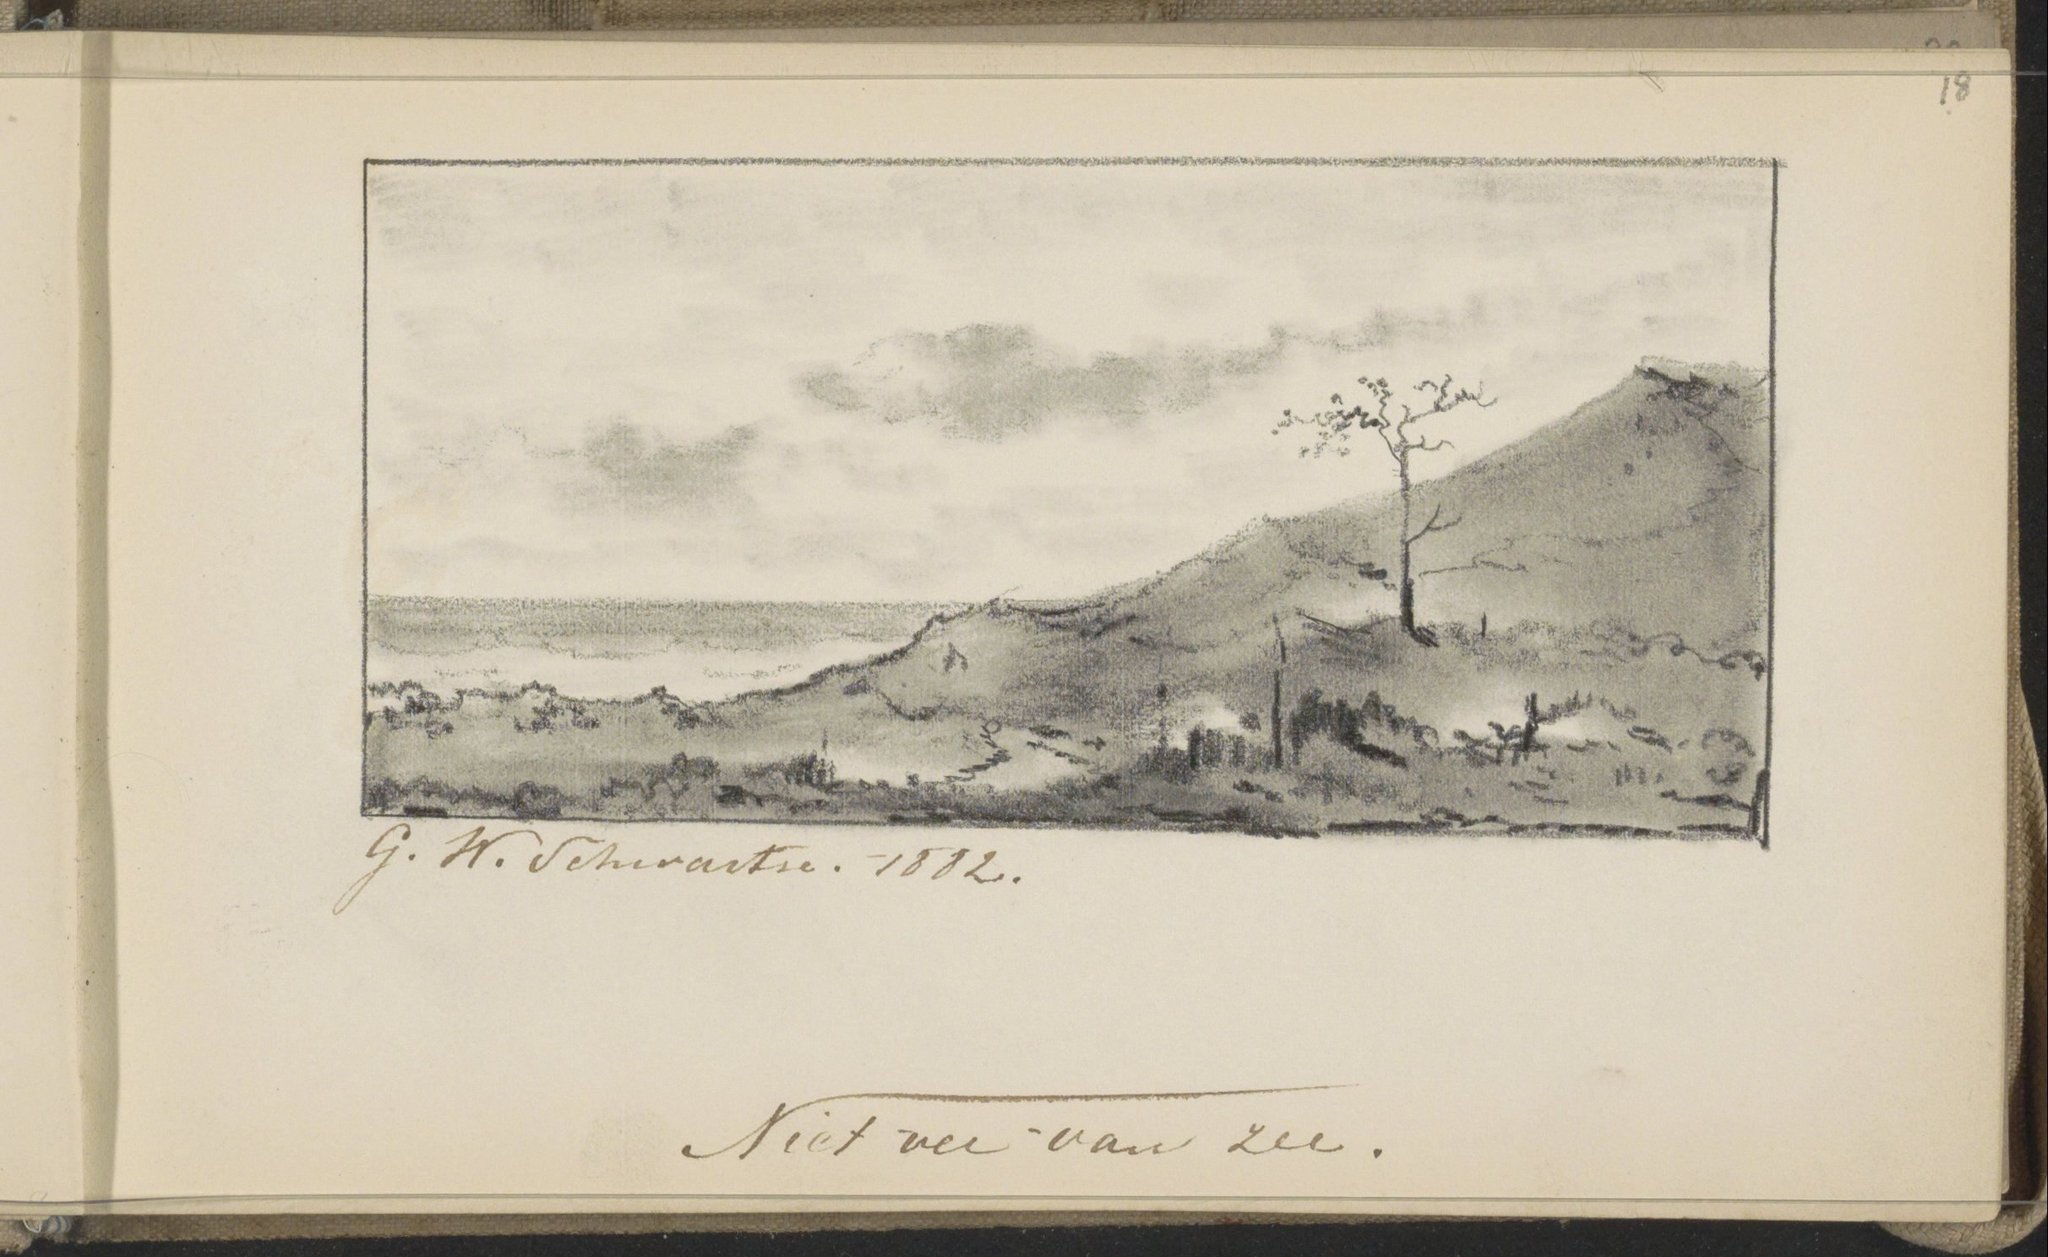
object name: sketchbook leaf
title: Duinlandschap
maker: george washington schwartze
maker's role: draughtsman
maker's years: 1857-1909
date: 1882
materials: paper, pencil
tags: dune coast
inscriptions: signature and date: ‘G.W.Schwartze. 1882.’, title: ‘Niet ver van zee.’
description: Tekening in een kader. Blad 18 recto uit een schetsboek met 54 bladen.